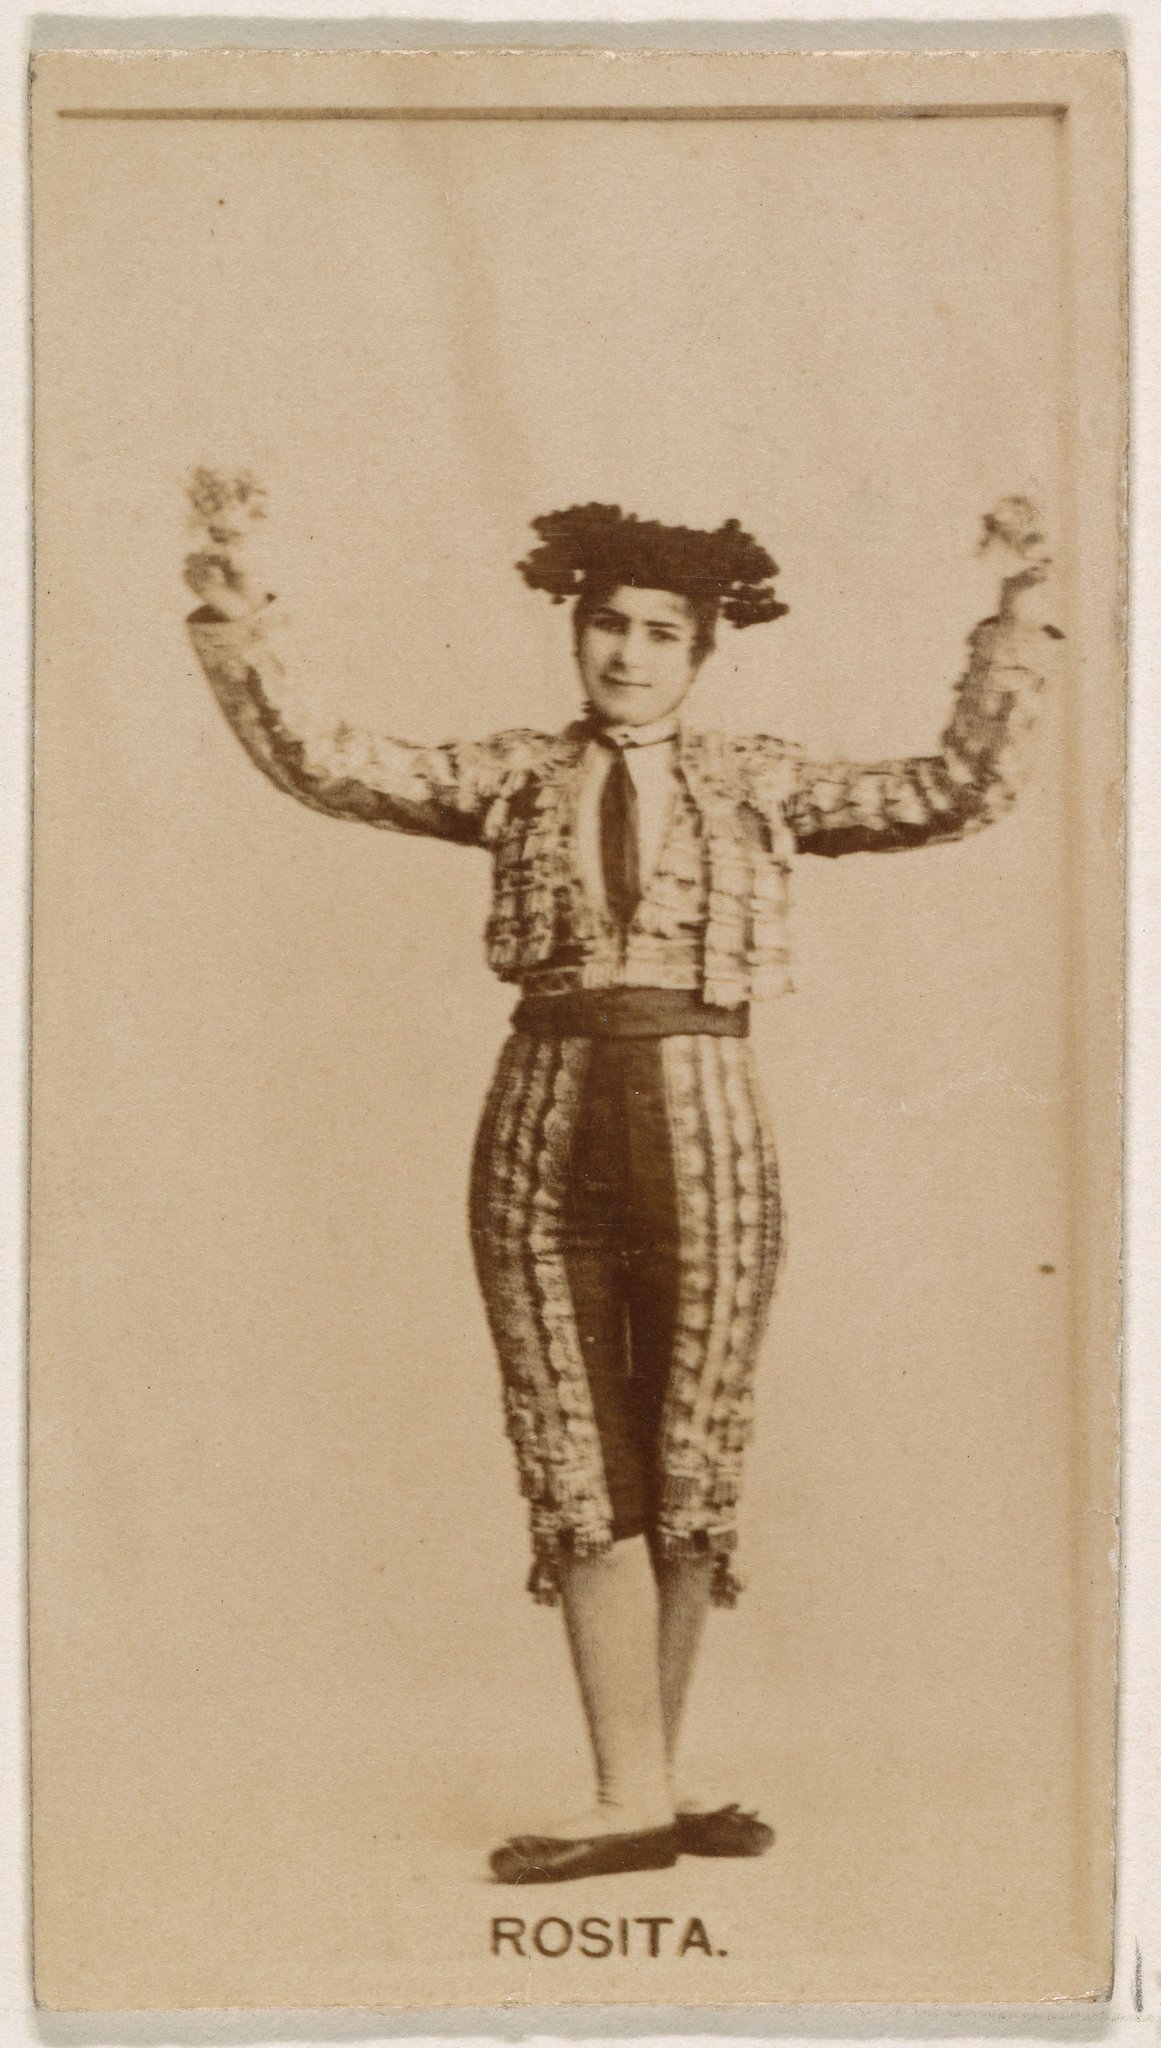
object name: photograph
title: Rosita, from the Actresses series (N245) issued by Kinney Brothers to promote Sweet Caporal Cigarettes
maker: kinney brothers tobacco company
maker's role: publisher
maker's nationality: american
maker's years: 1869-2011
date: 1890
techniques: albumen silver print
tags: portraits,women,actresses